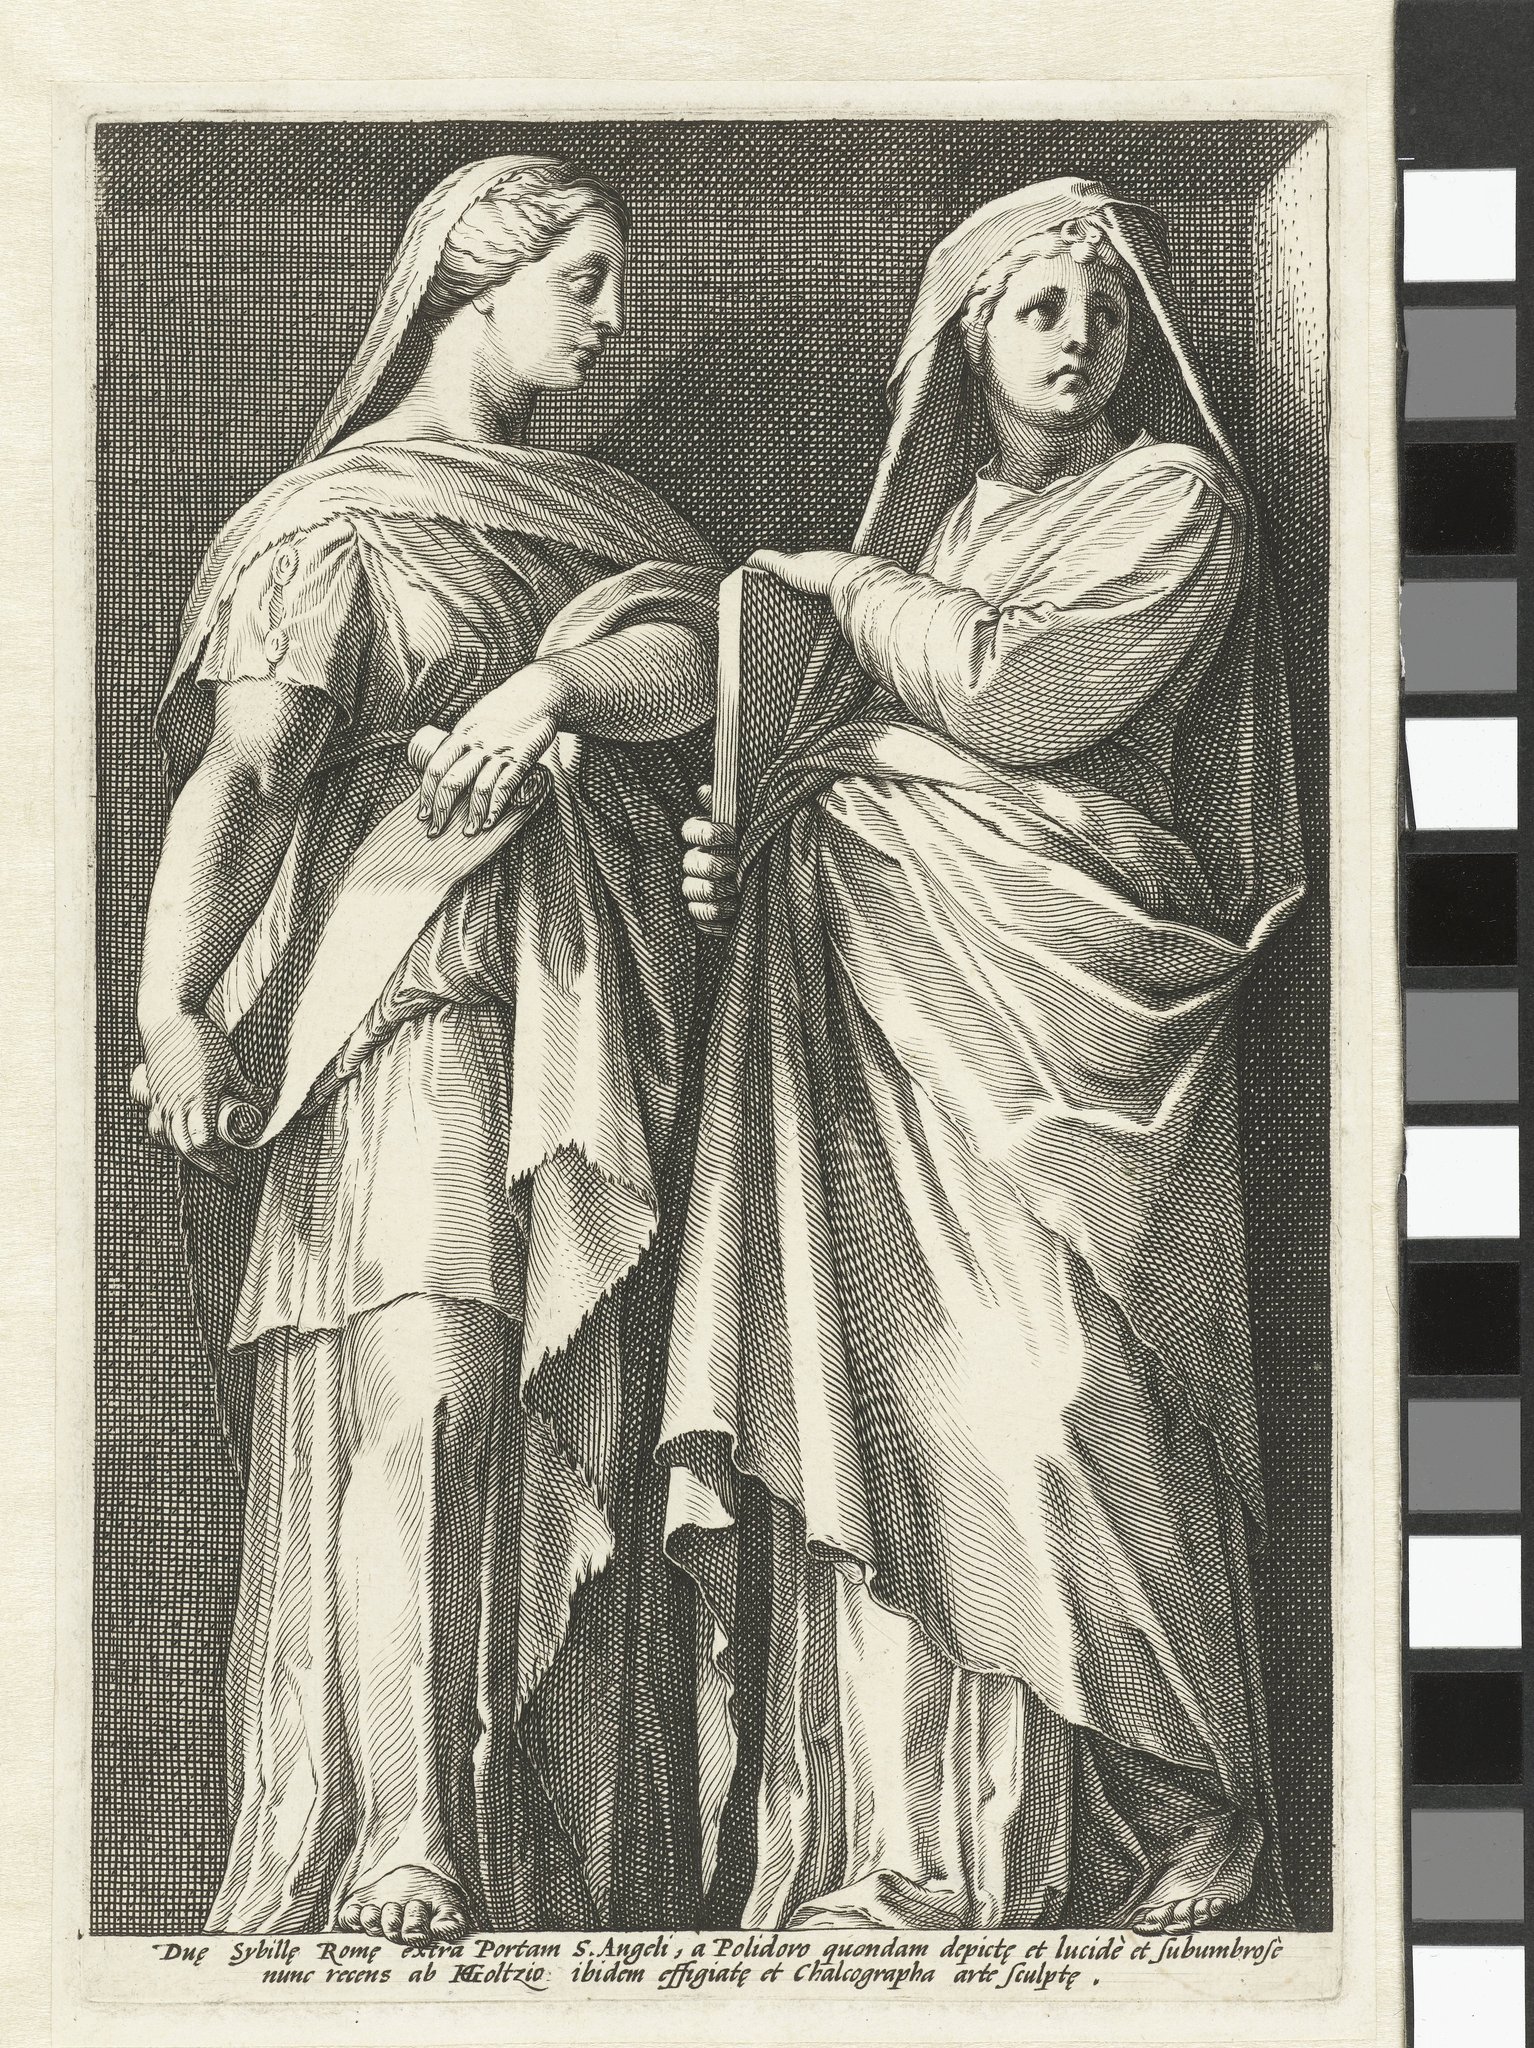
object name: print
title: Twee sibillen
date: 1592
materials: paper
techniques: engraving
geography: haarlem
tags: sibyls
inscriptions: collector's mark: Lugt 240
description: Twee vrouwen, ten voeten uit, de een met een boekrol in de handen, de ander met een boek of tablet in de handen. Onder de voorstelling twee regels tekst in Latijn.